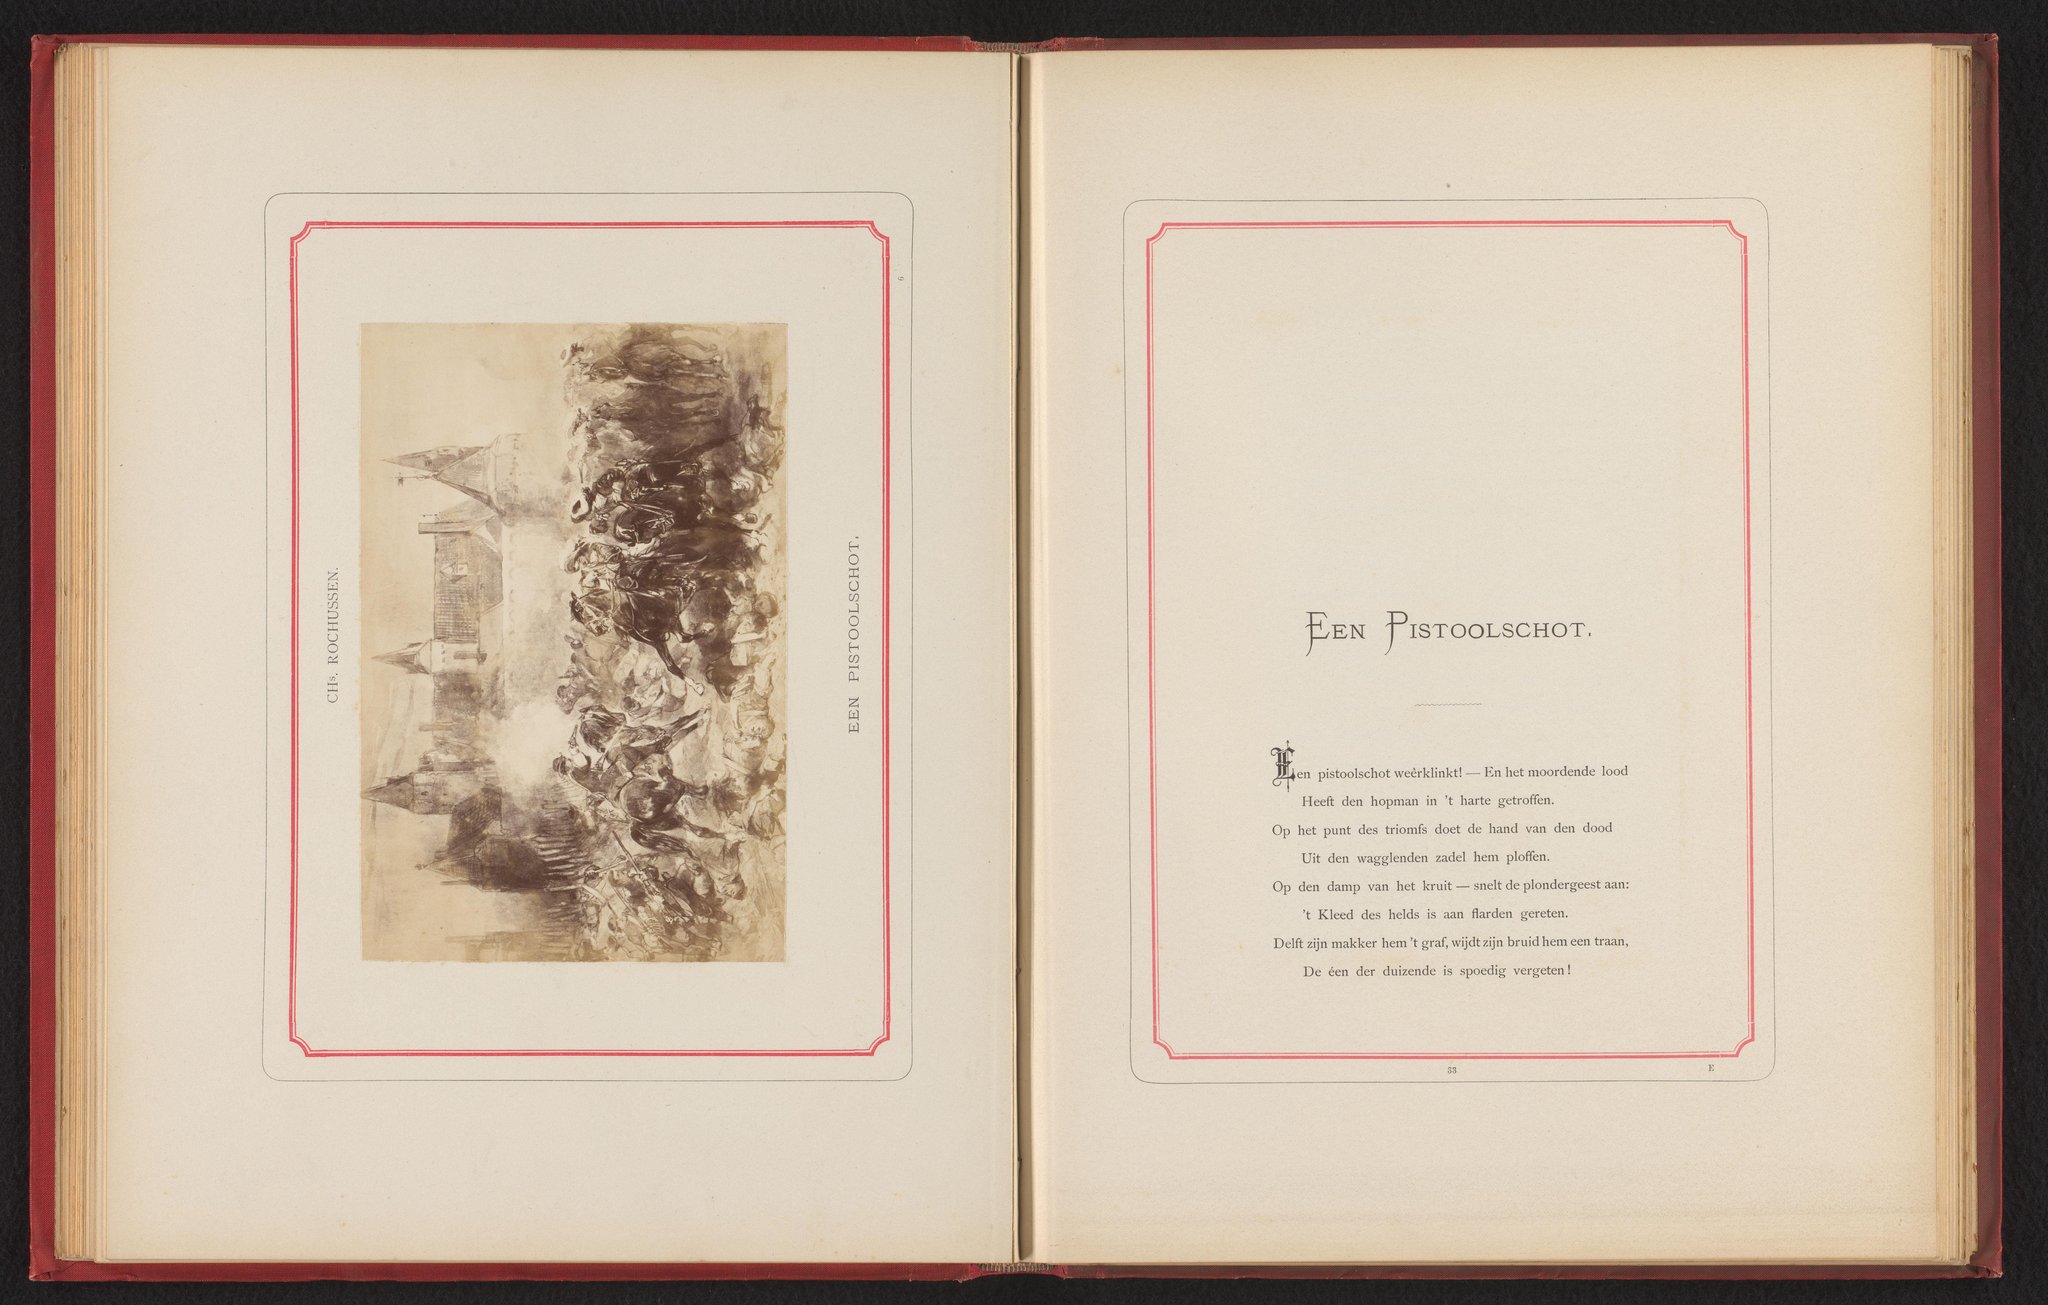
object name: reproduction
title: Fotoreproductie van het schilderij 'Een pistoolschot' door Charles Rochussen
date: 1865-1878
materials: paper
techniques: albumen print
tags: battle